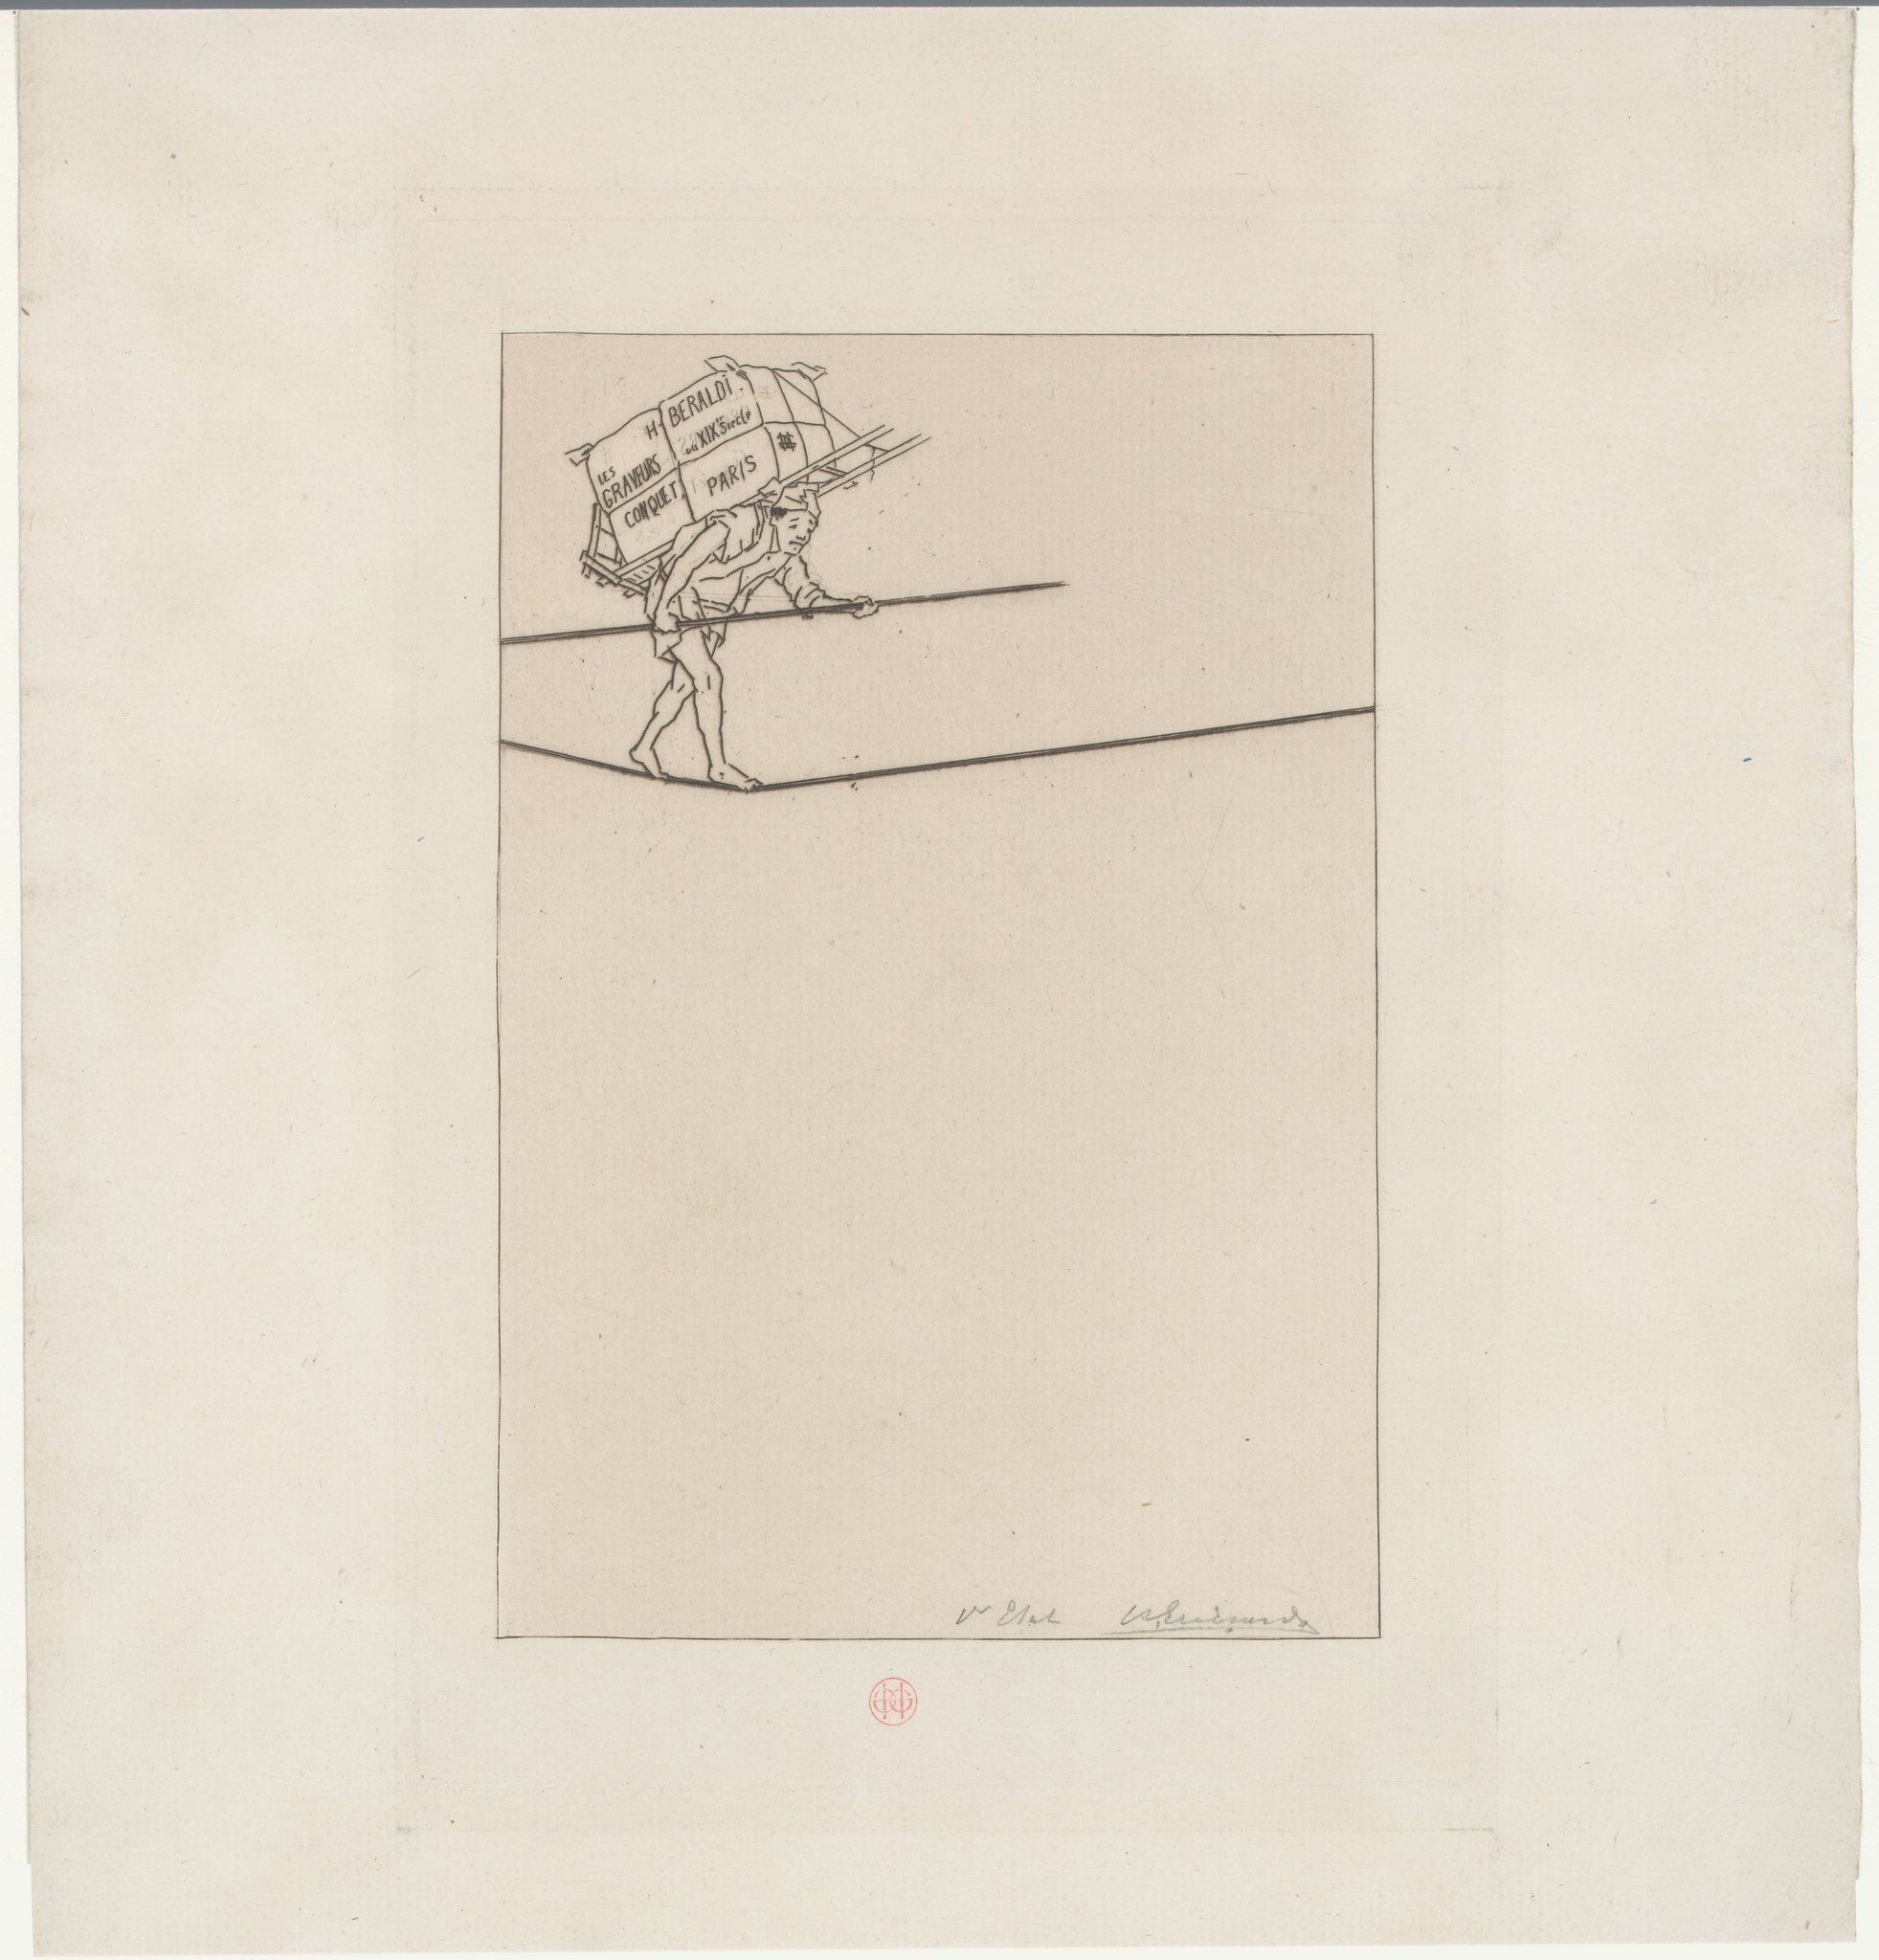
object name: print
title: Titelpagina voor: Henri Béraldi, Les Graveurs du XIXe siècle (...), 1888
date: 1856-1897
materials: paper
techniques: etching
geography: paris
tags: tight-ropewalker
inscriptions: collector's mark: Lugt 2228, annotation: ‘1e Etat’, stamp: Lugt 1157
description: Titelpagina voor: Béraldi, Henri. Les Graveurs du XIXe siècle : guide de l'amateur d'estampes modernes. Parijs: L. Conquet, 1885-1892, dl. 7 (1888).